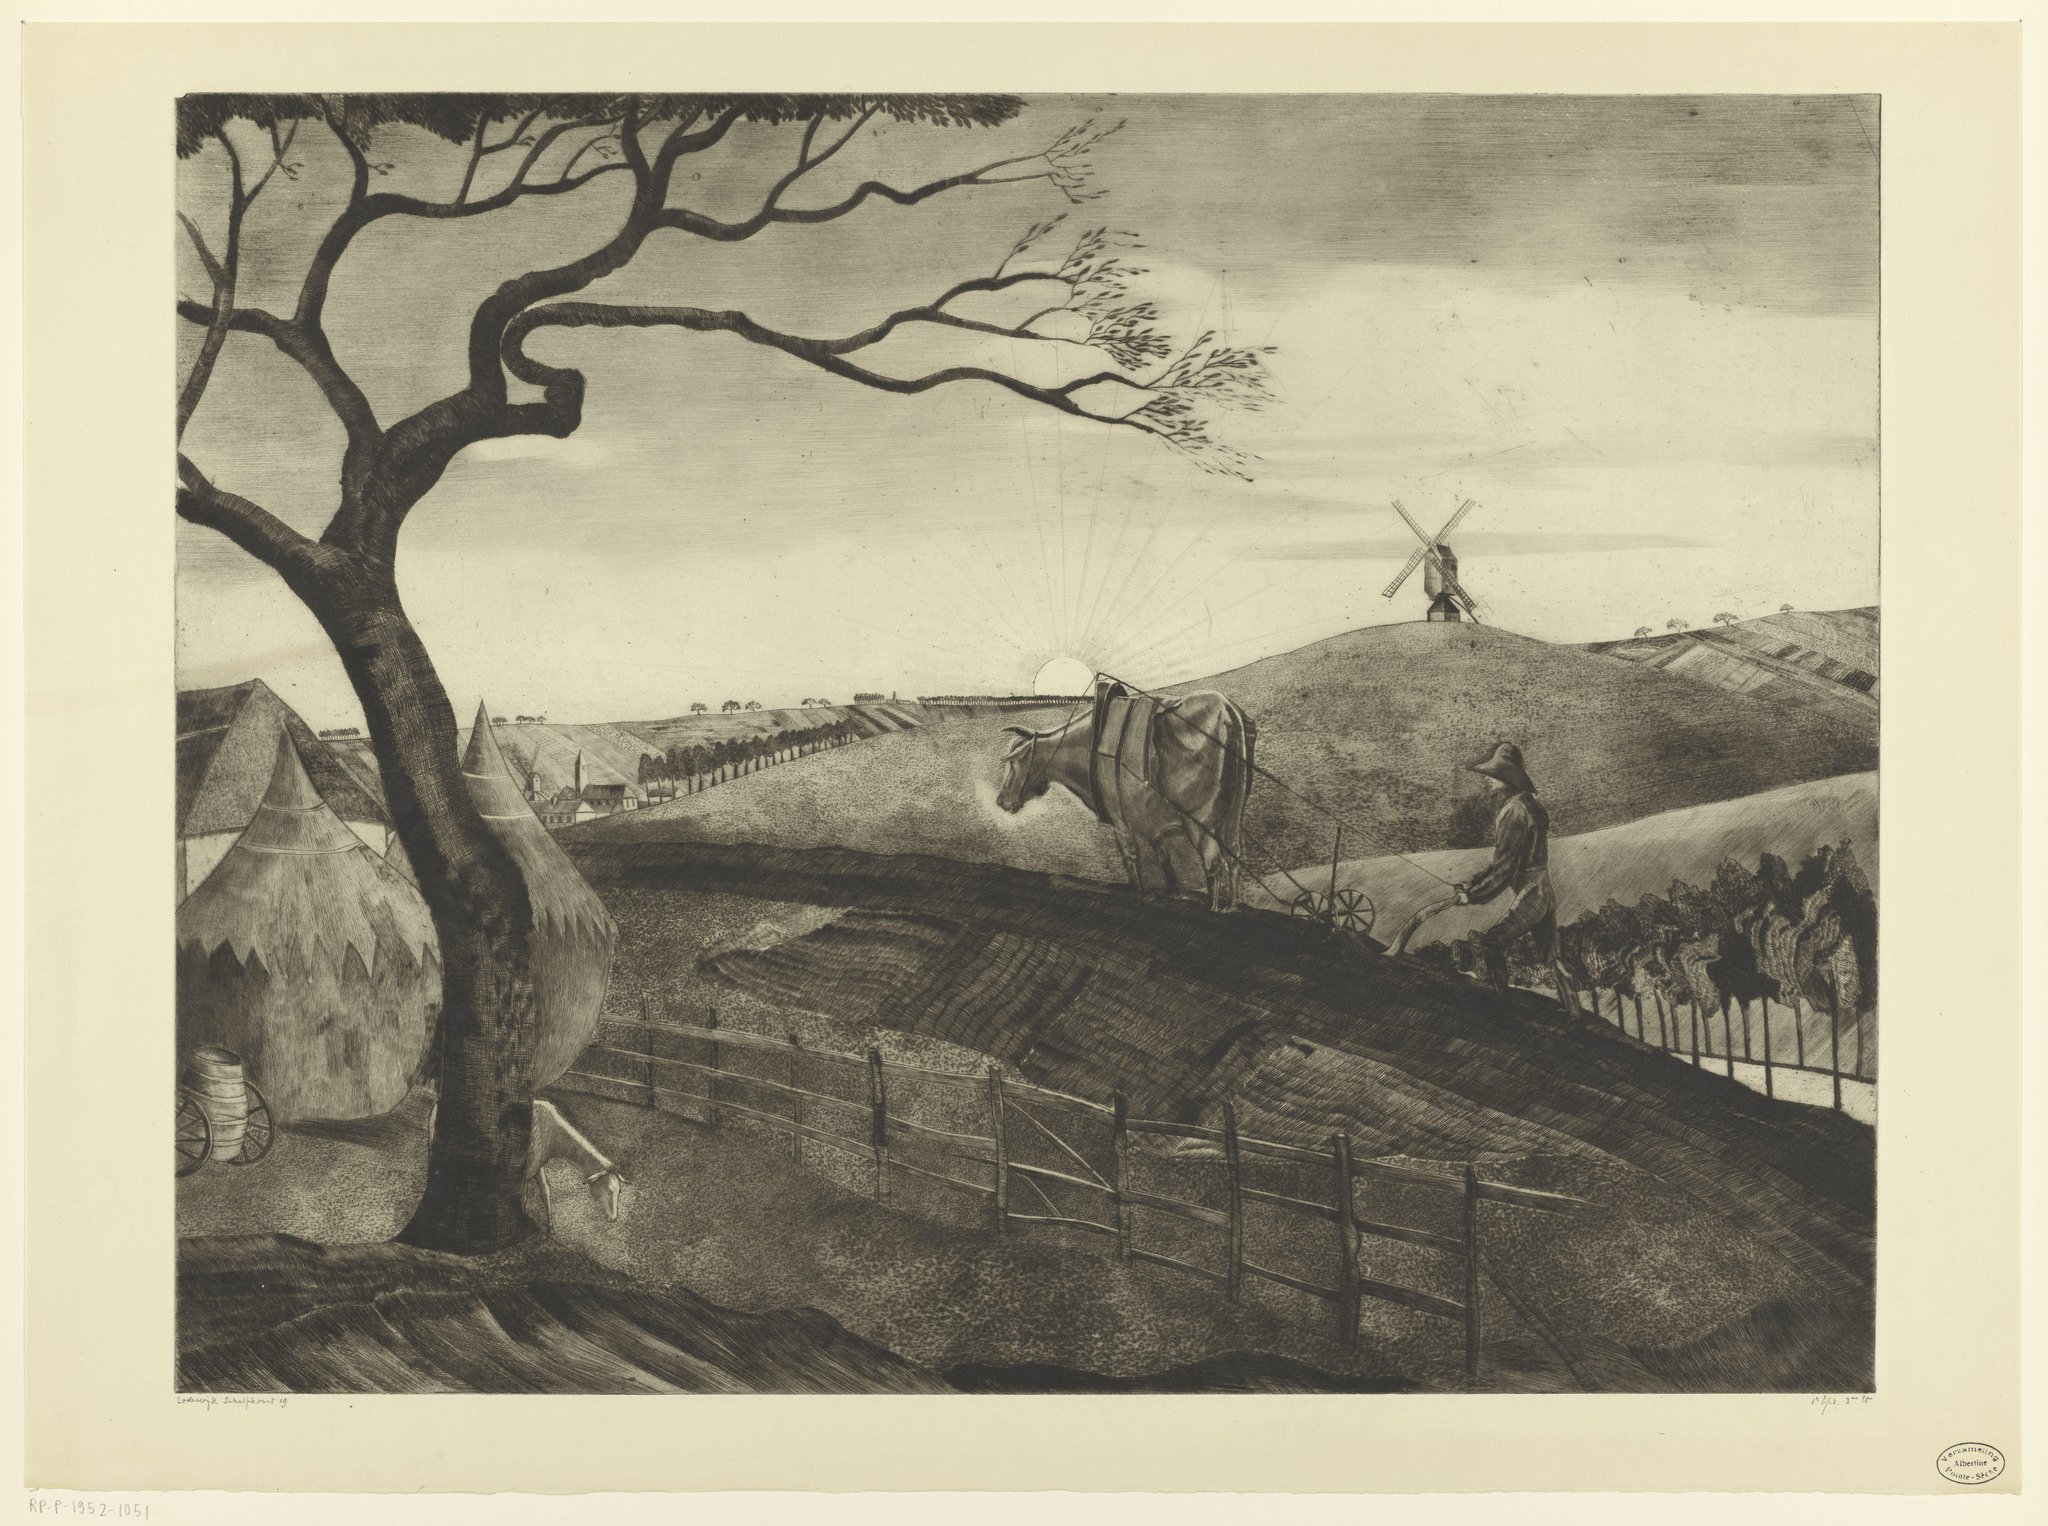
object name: print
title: Ploegende boer met een os bij Etikhove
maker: lodewijk schelfhout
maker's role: draughtsman, print maker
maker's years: 1881-1943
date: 1926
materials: paper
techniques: drypoint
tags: low hill country, windmill in landscape, ox, ploughing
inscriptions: collector's mark: Lugt 5i, collector's mark: Lugt 2228, collector's mark: Lugt 2760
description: Het heuvellandschap bij de plaats Etikhove in de Belgische provincie Oost-Vlaanderen. Links op de voorgrond een weiland met een schaap, boom en twee hooischelven. Rechts op de voorgrond een man en een os die een akker ploegen. Op de achtergrond meerdere nederzettingen en een molen. Boven het landschap de opgaande of ondergaande zon.